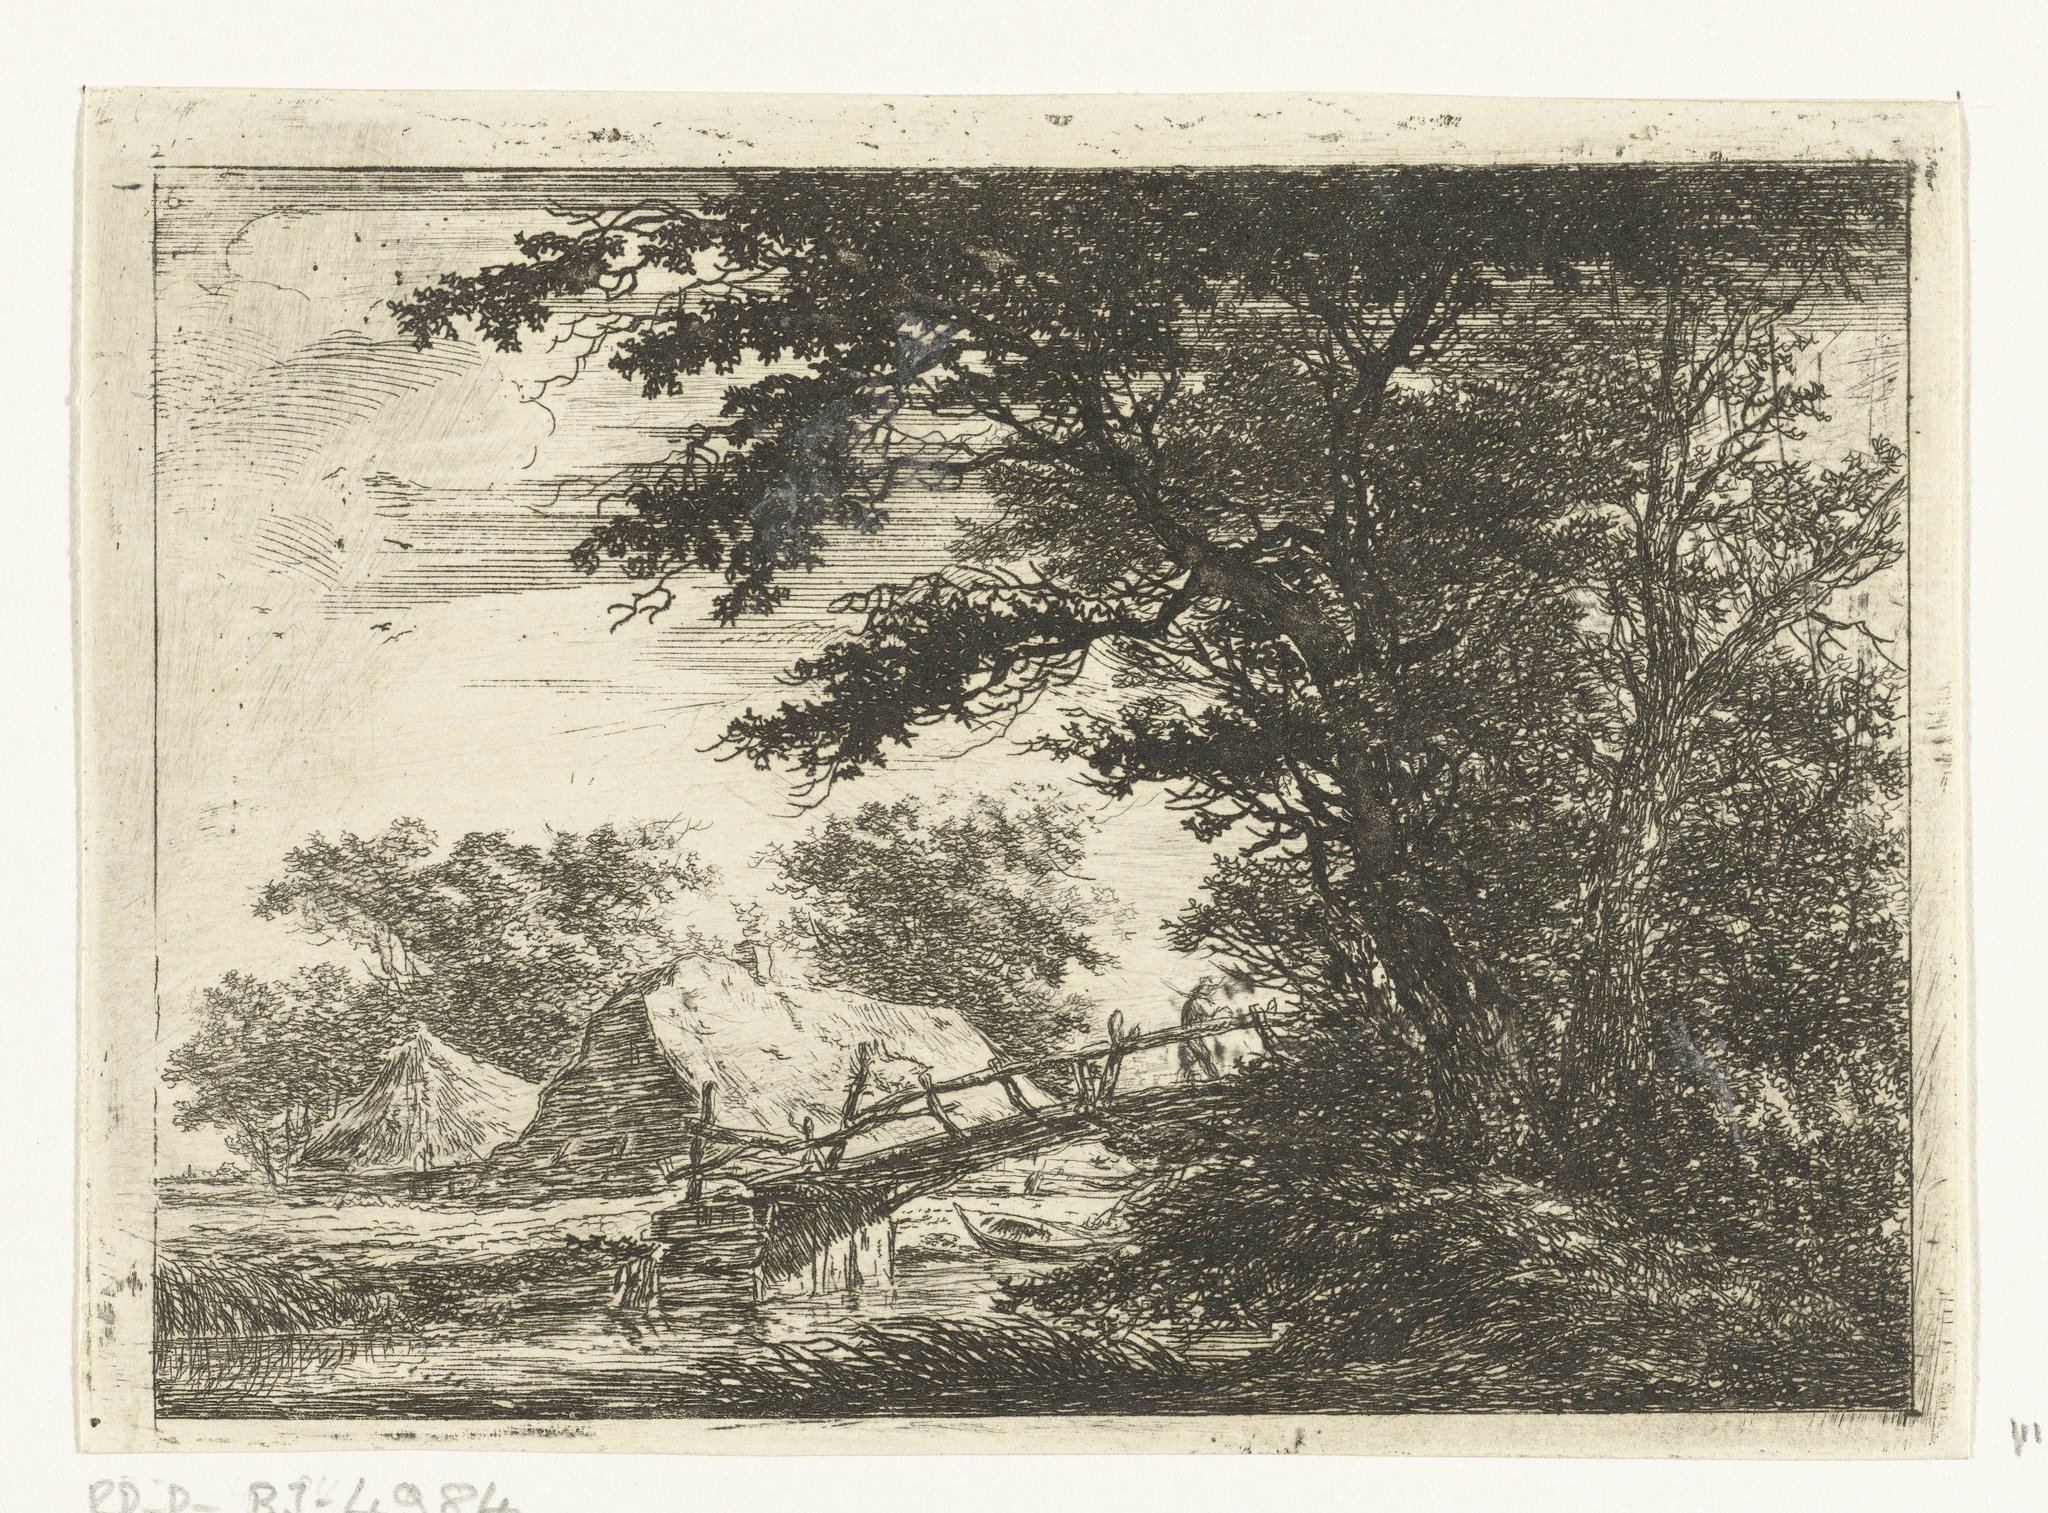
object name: print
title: Houten brug bij huizen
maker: hermanus van brussel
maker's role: draughtsman, print maker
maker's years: 1763-1815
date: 1800-1815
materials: paper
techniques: etching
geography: netherlands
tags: landscapes in the temperate zone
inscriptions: collector's mark: Lugt 2228